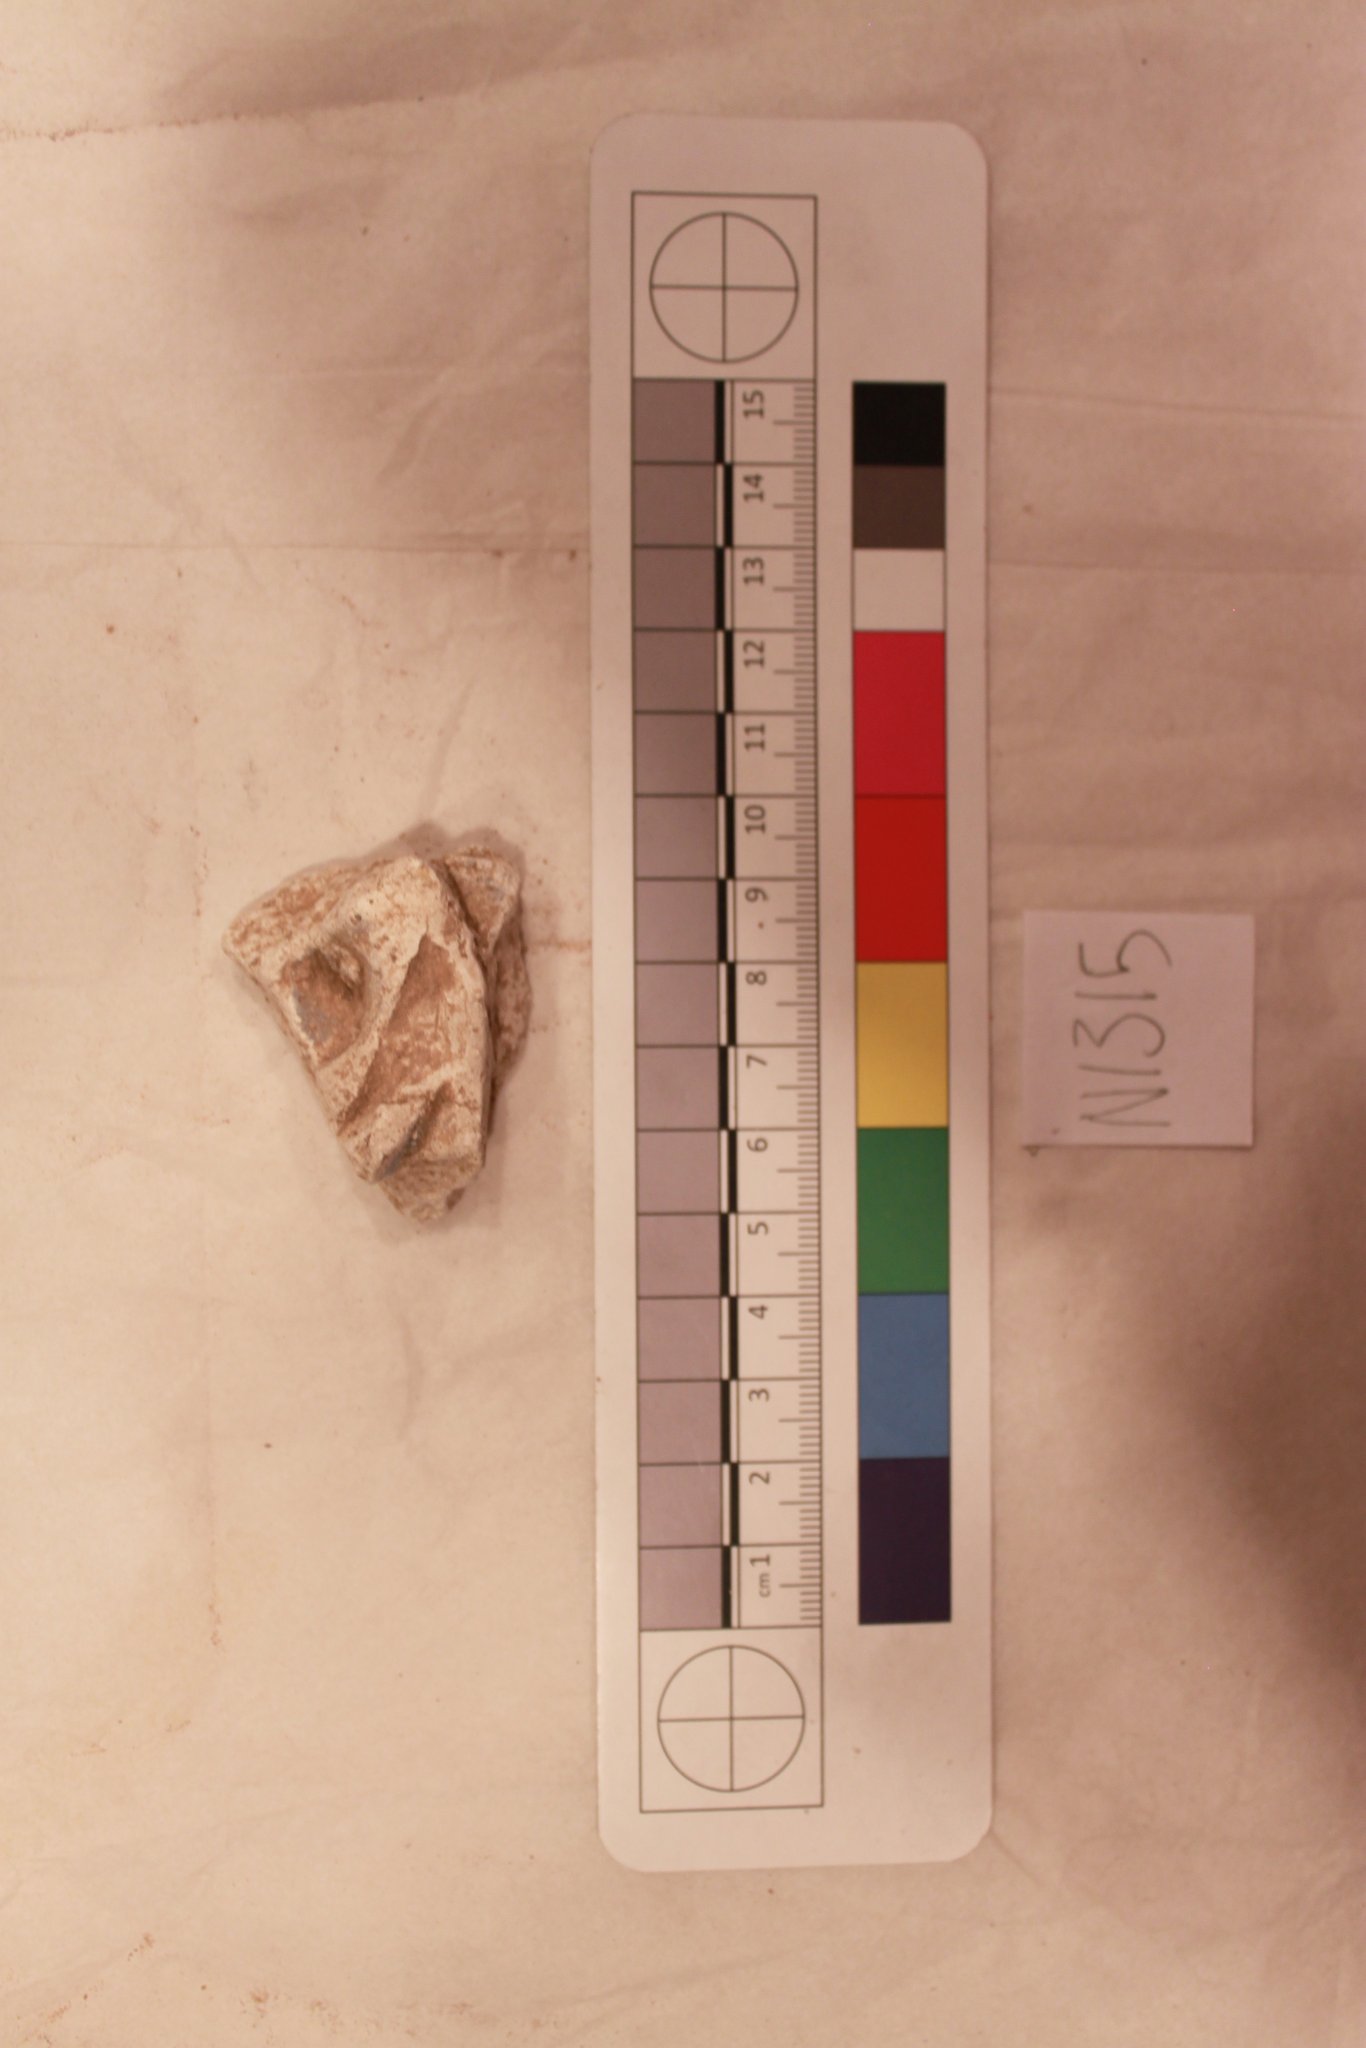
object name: fragment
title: Stucco Fragment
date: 701-1200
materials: plaster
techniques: carving, painting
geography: iran